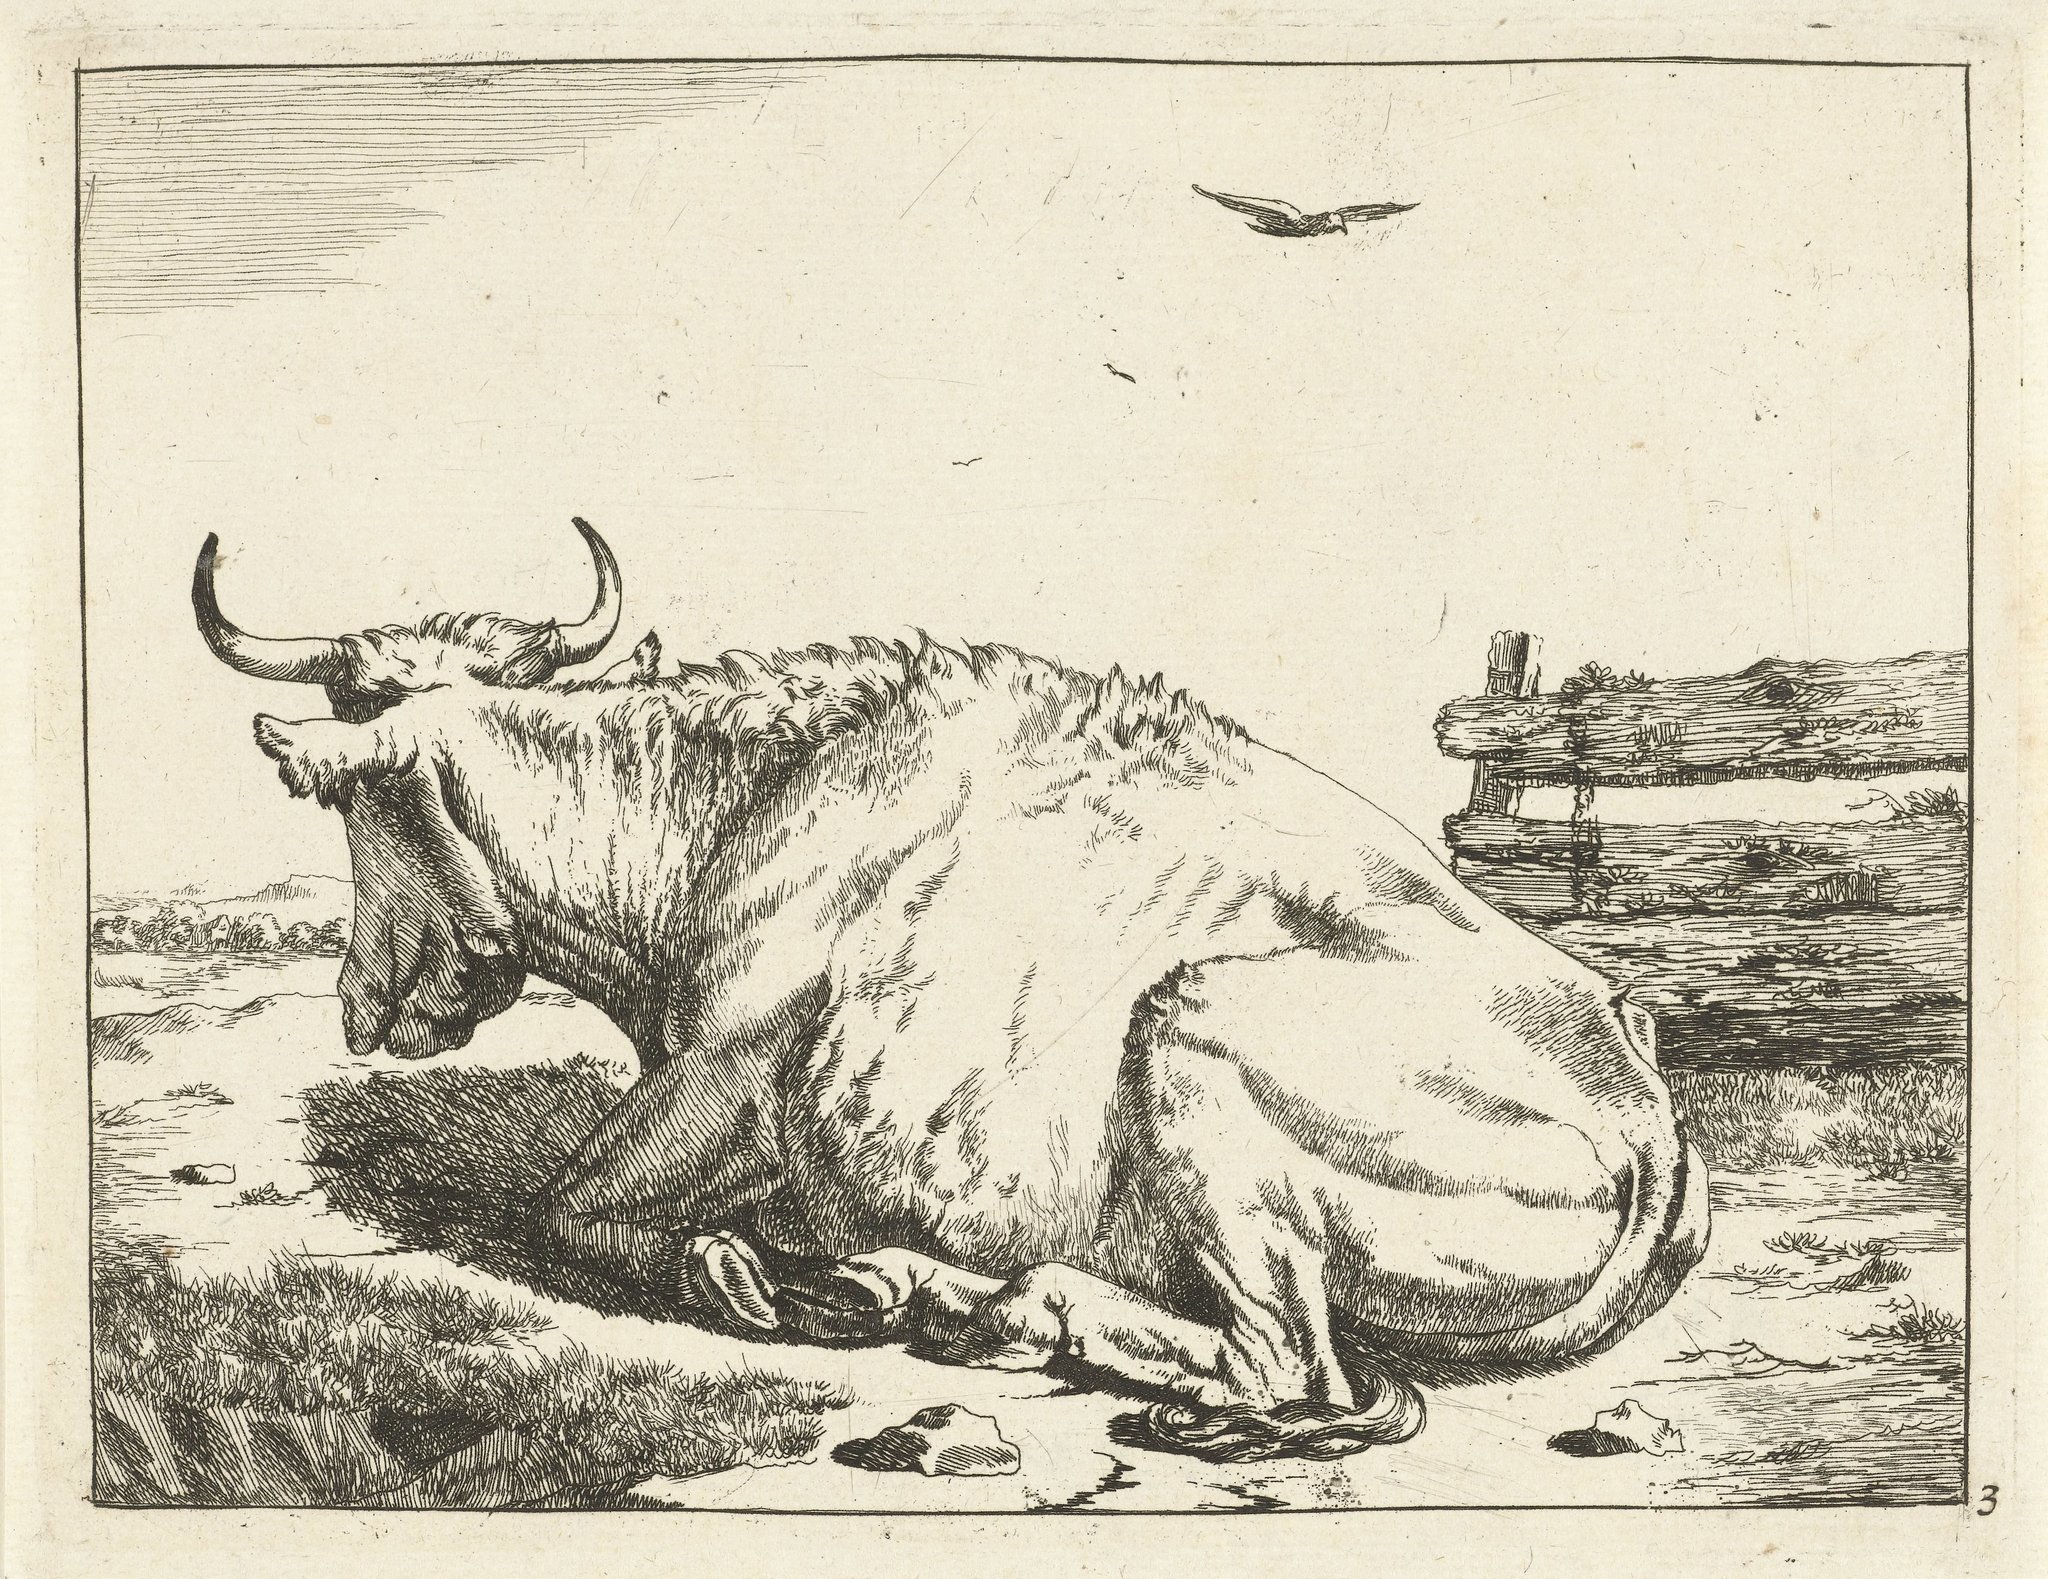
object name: print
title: Koe liggend bij hek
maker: marcus de bye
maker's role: print maker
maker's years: 1639-1688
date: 1657-1677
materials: paper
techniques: etching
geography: the hague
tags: cow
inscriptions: collector's mark: Lugt 2228